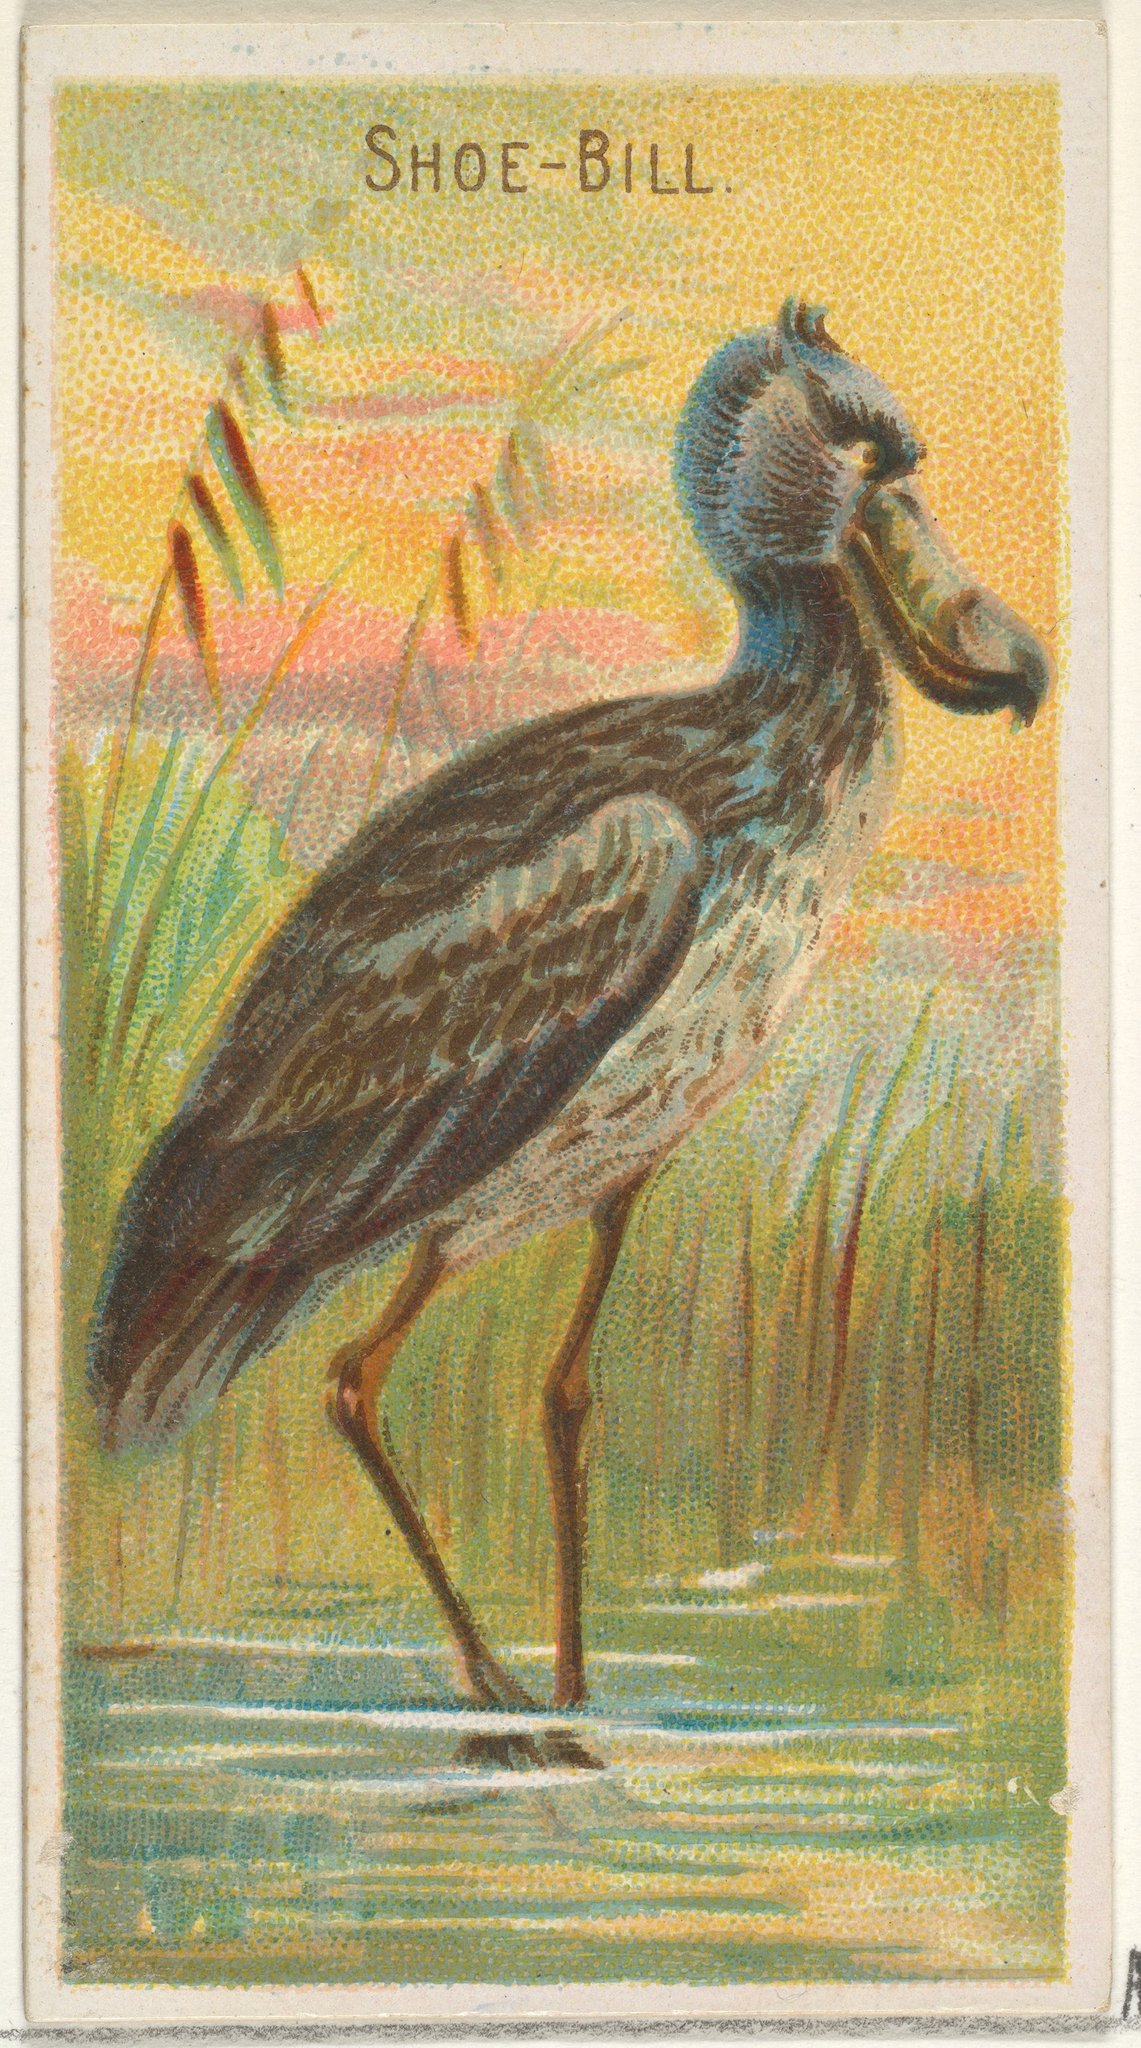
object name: print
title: Shoe-Bill, from the Birds of the Tropics series (N5) for Allen & Ginter Cigarettes Brands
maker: allen & ginter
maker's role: publisher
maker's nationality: american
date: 1889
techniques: color lithograph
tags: birds